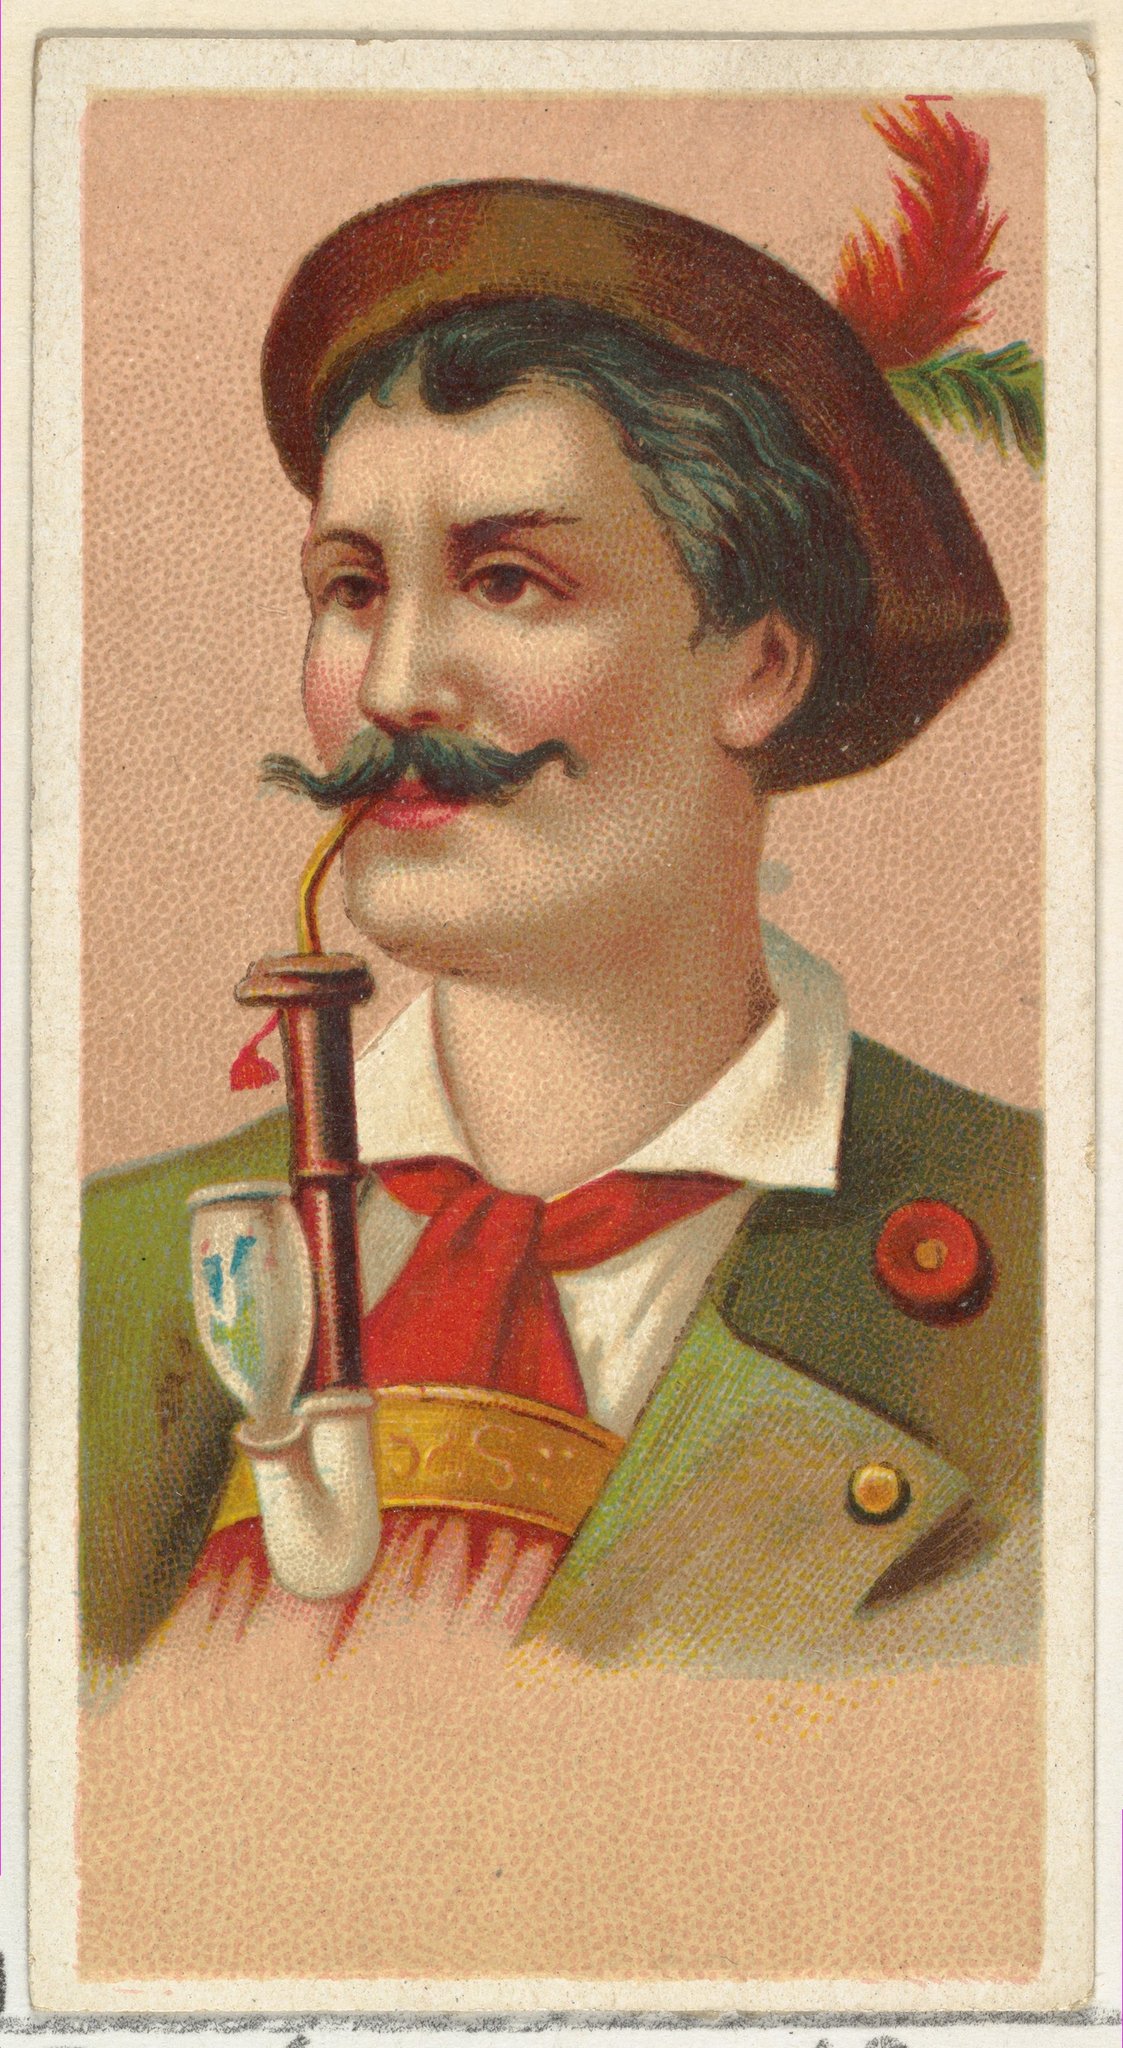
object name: print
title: Bavarian Hunter, printer's sample from World's Smokers series (N33) for Allen & Ginter Cigarettes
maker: allen & ginter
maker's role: publisher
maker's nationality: american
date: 1888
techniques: color lithograph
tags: men,smoking